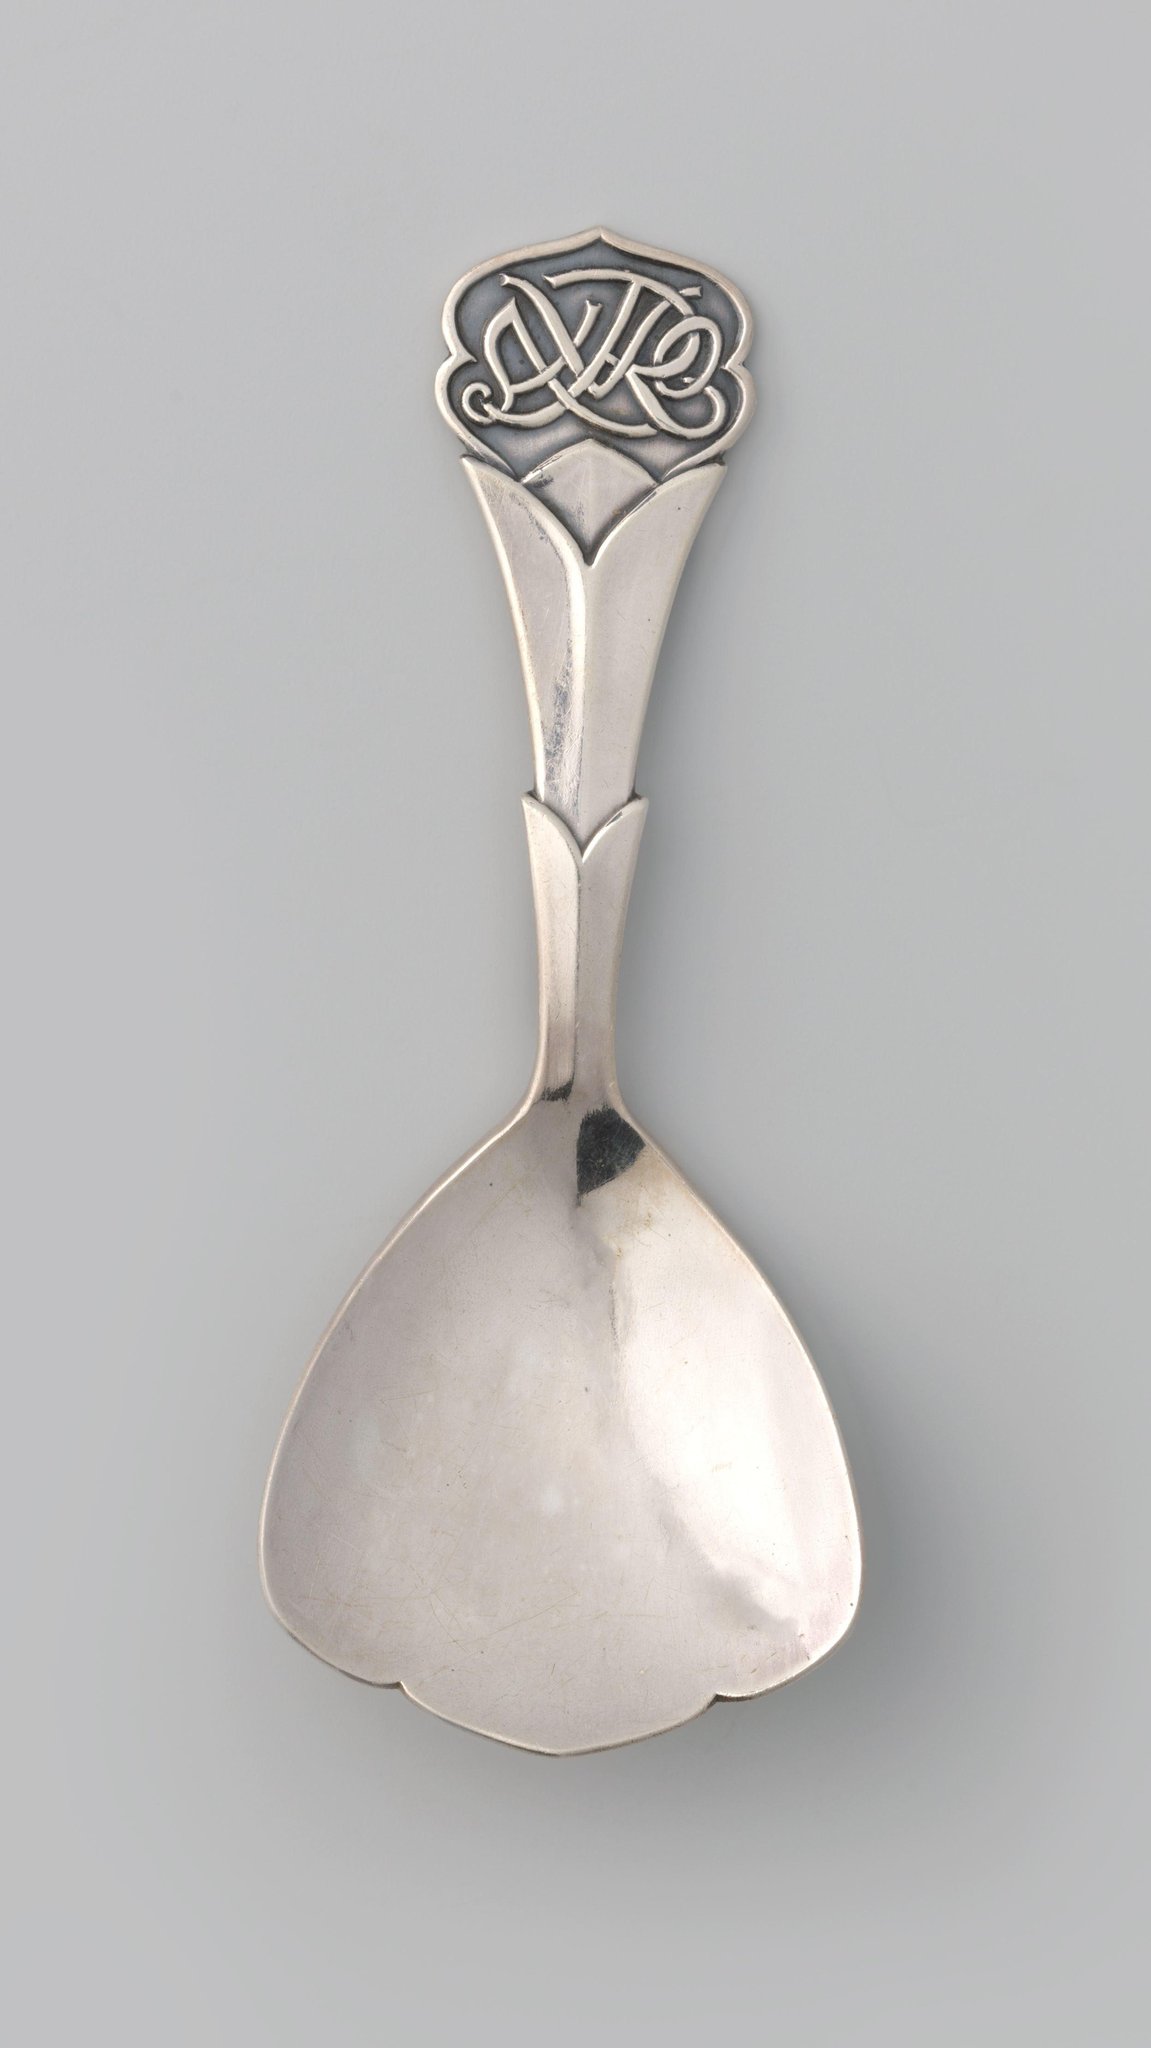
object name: suikerschep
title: Suikerlepel AVRO, zomer 1937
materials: metal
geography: zeist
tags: netherlands